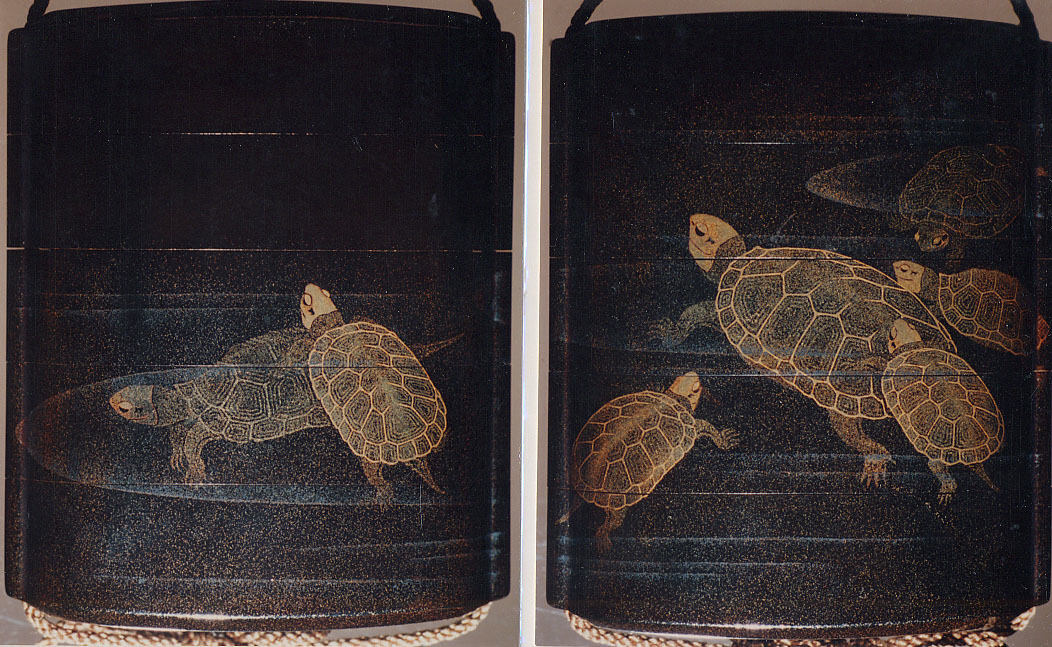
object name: inrō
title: Case (Inrō) with Design of Tortoises Swimming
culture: japanese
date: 1701-1900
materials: gold, lacquer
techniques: fundame, roiro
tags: turtles